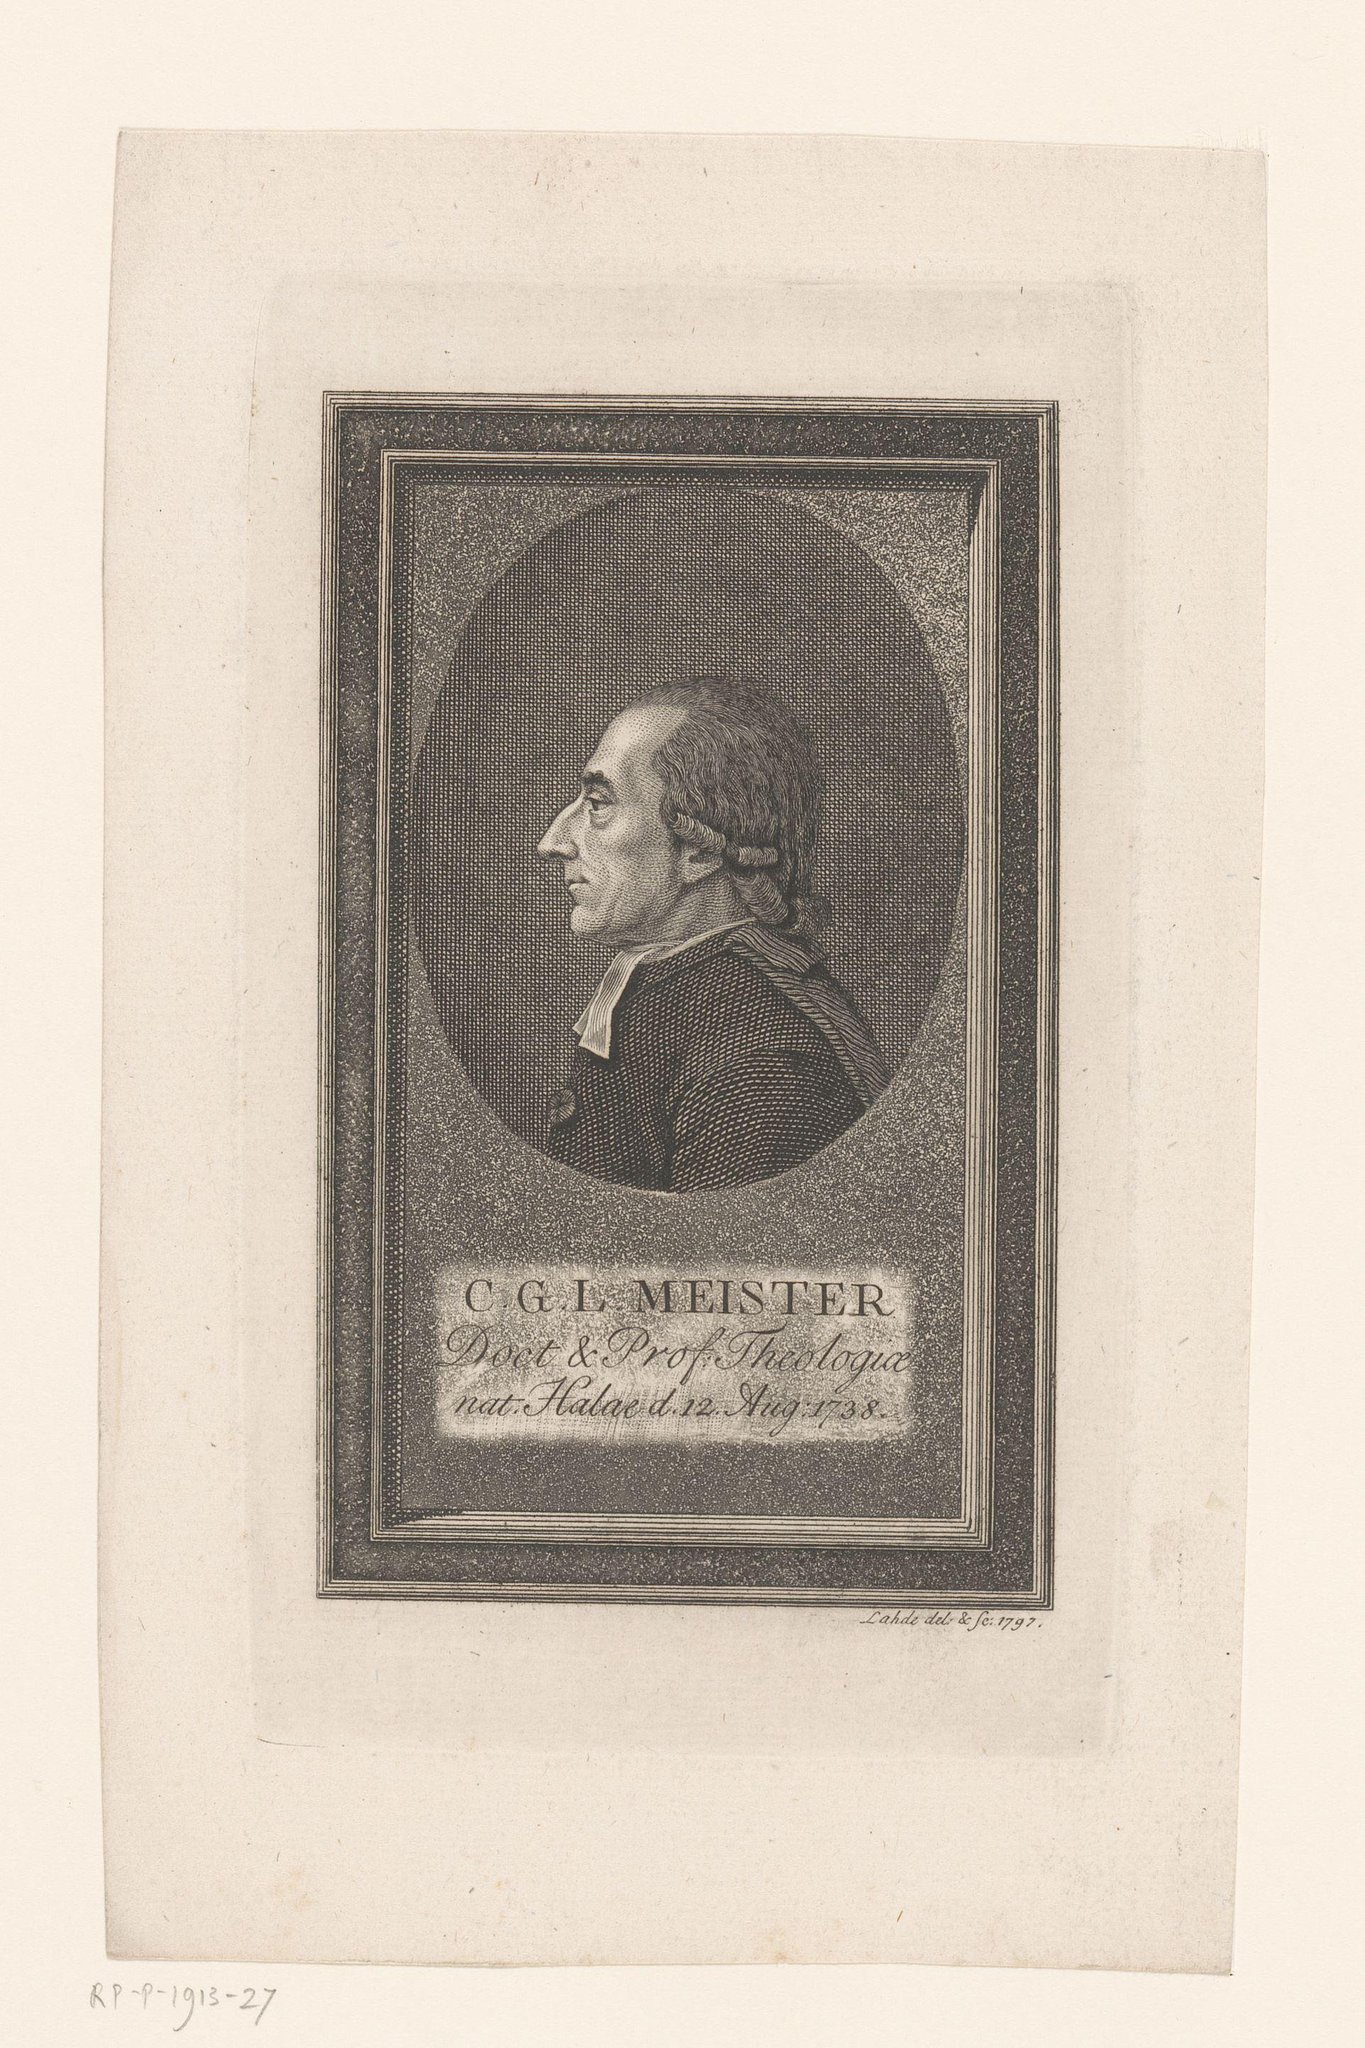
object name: print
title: Portret van Christoph Georg Ludwig Meister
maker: gerhard ludwig lahde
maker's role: goldsmith, print maker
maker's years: 1765-1833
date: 1797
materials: paper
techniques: aquatint, engraving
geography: denmark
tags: historical persons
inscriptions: collector's mark: Lugt 2228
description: Portret van Christoph Georg Ludwig Meister, professor theologie.